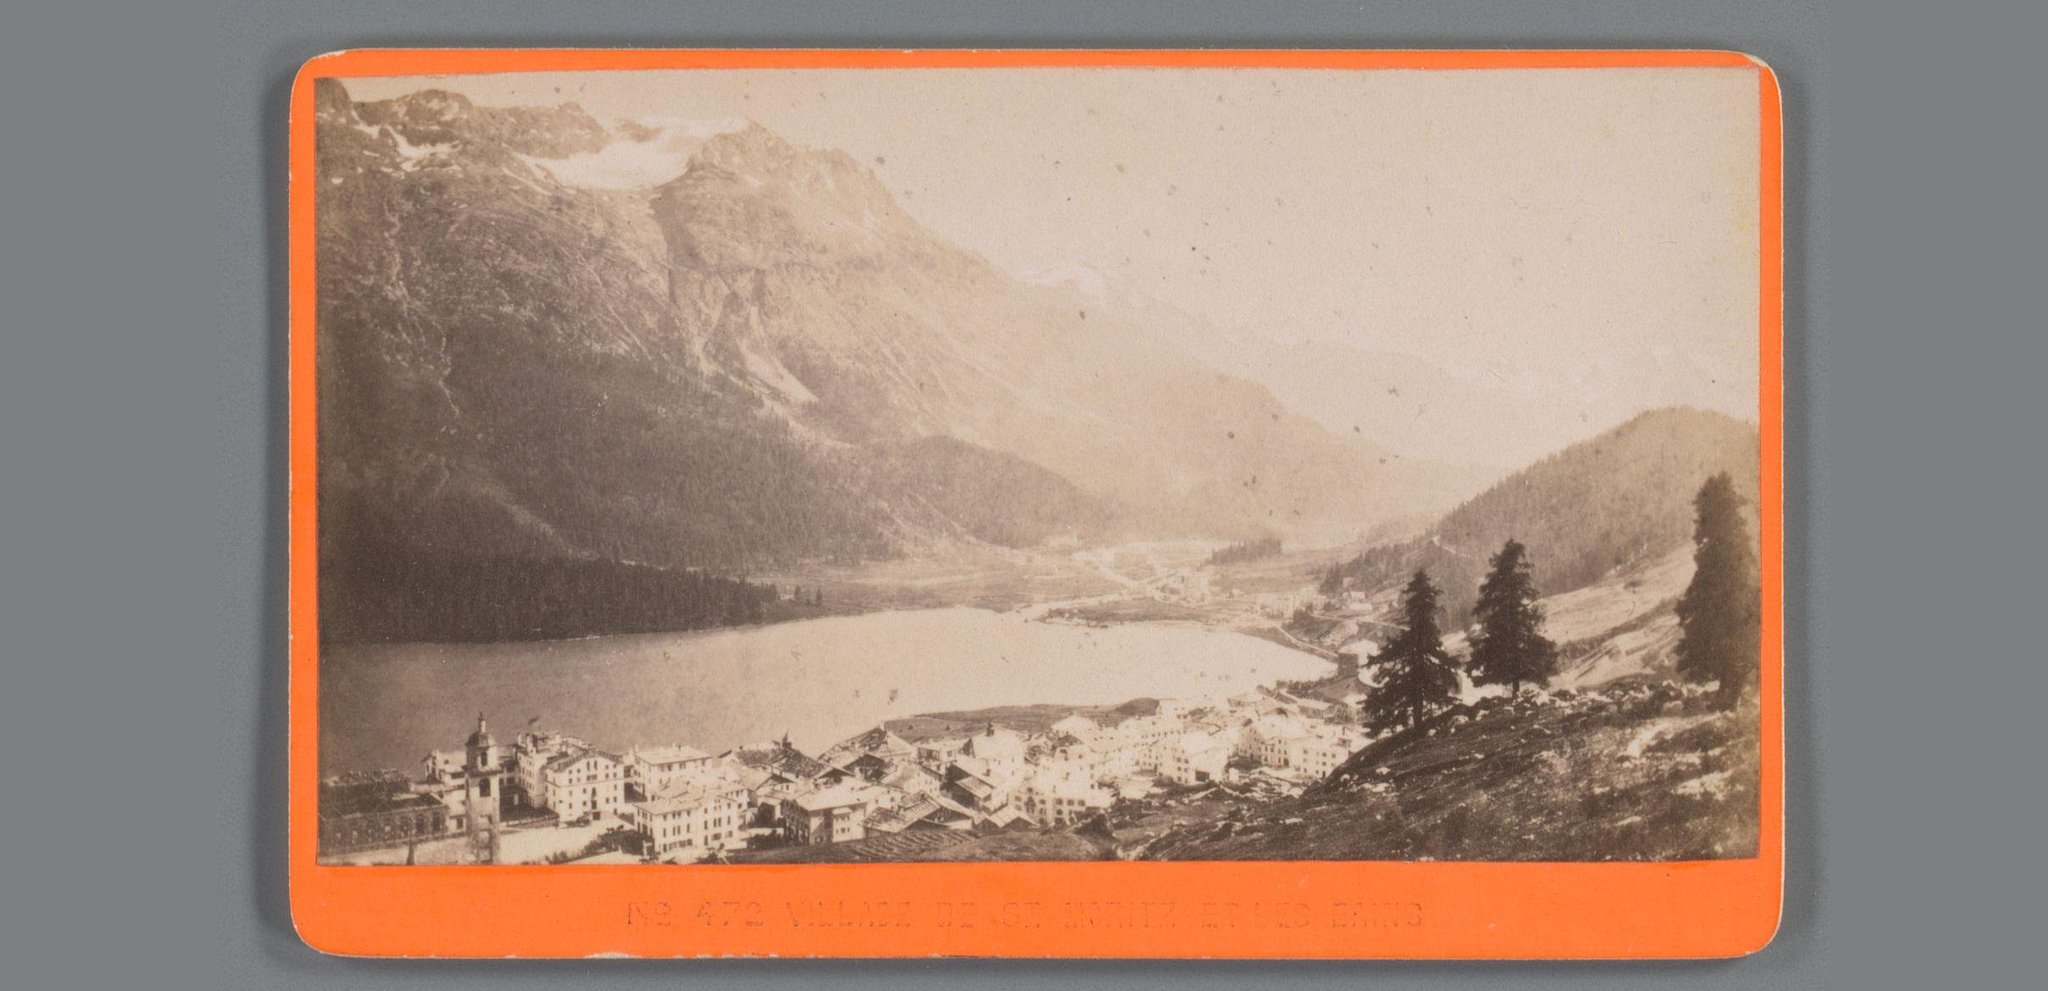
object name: carte de visite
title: Village de St Moritz et les Bains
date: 1876-1883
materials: cardboard, paper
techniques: albumen print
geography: sankt moritz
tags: meer van sankt moritz, sankt moritz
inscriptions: inscription: ‘PARIS 1870/ LYON 1872/ VIENNE 1873/ PHILADELPHIA 1876/ MAISON DES TROIS ROIS’, number: ‘No 472’